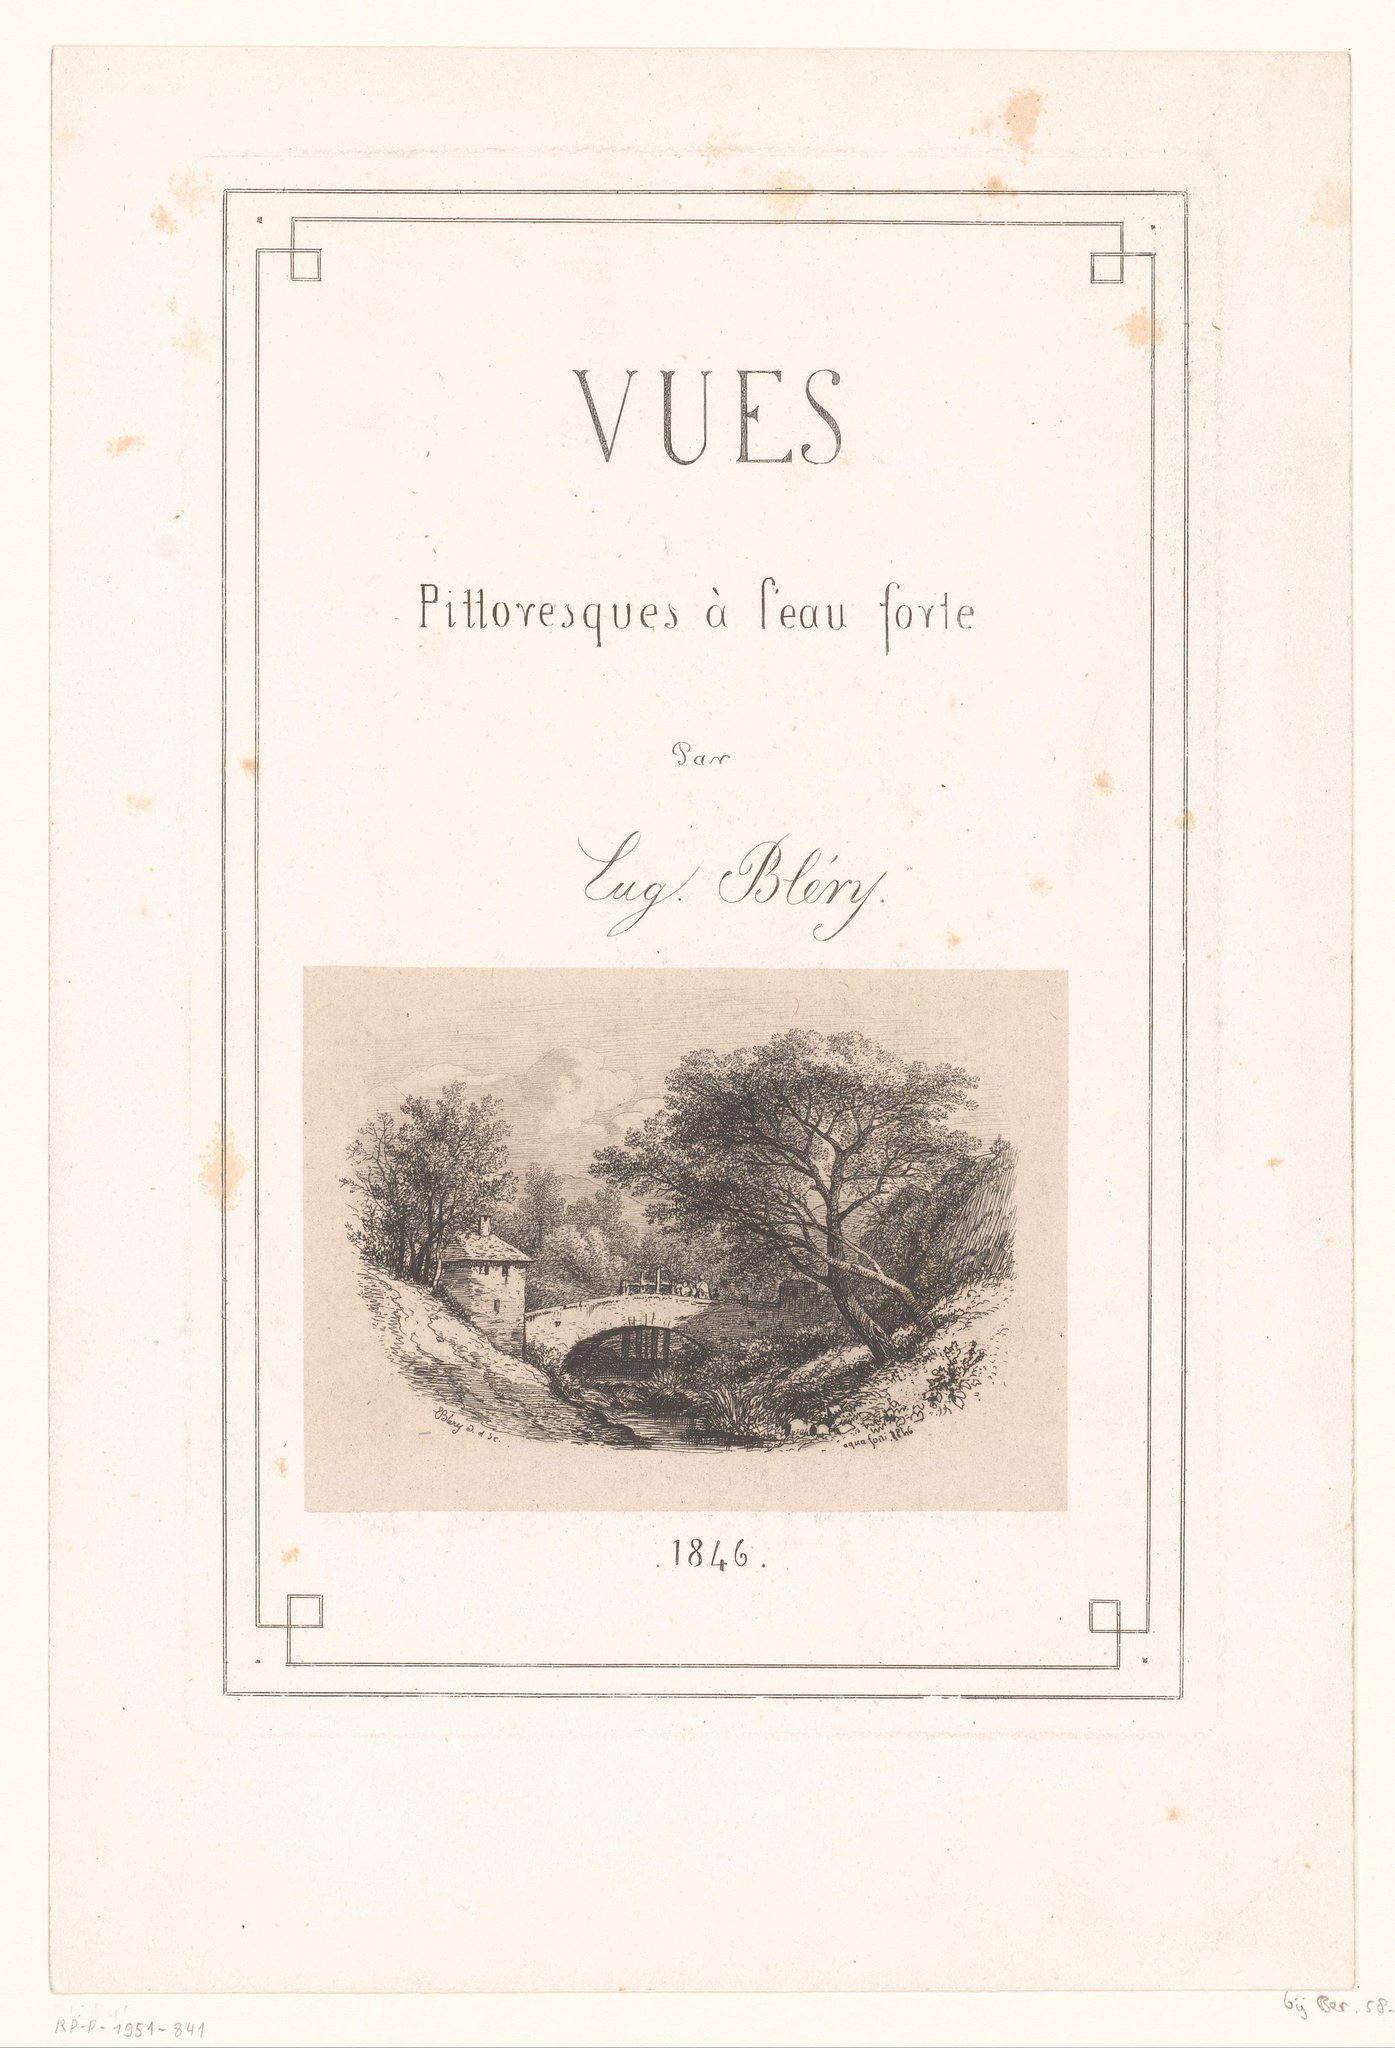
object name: titelprent, frontispice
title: Vues Pittoresques à l'eau forte par Eug. Bléry.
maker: eugène bléry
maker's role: print maker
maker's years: 1805-1887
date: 1846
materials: paper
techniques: drypoint, etching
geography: fontainebleau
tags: landscape with bridge, viaduct or aqueduct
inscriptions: collector's mark: Lugt 2228